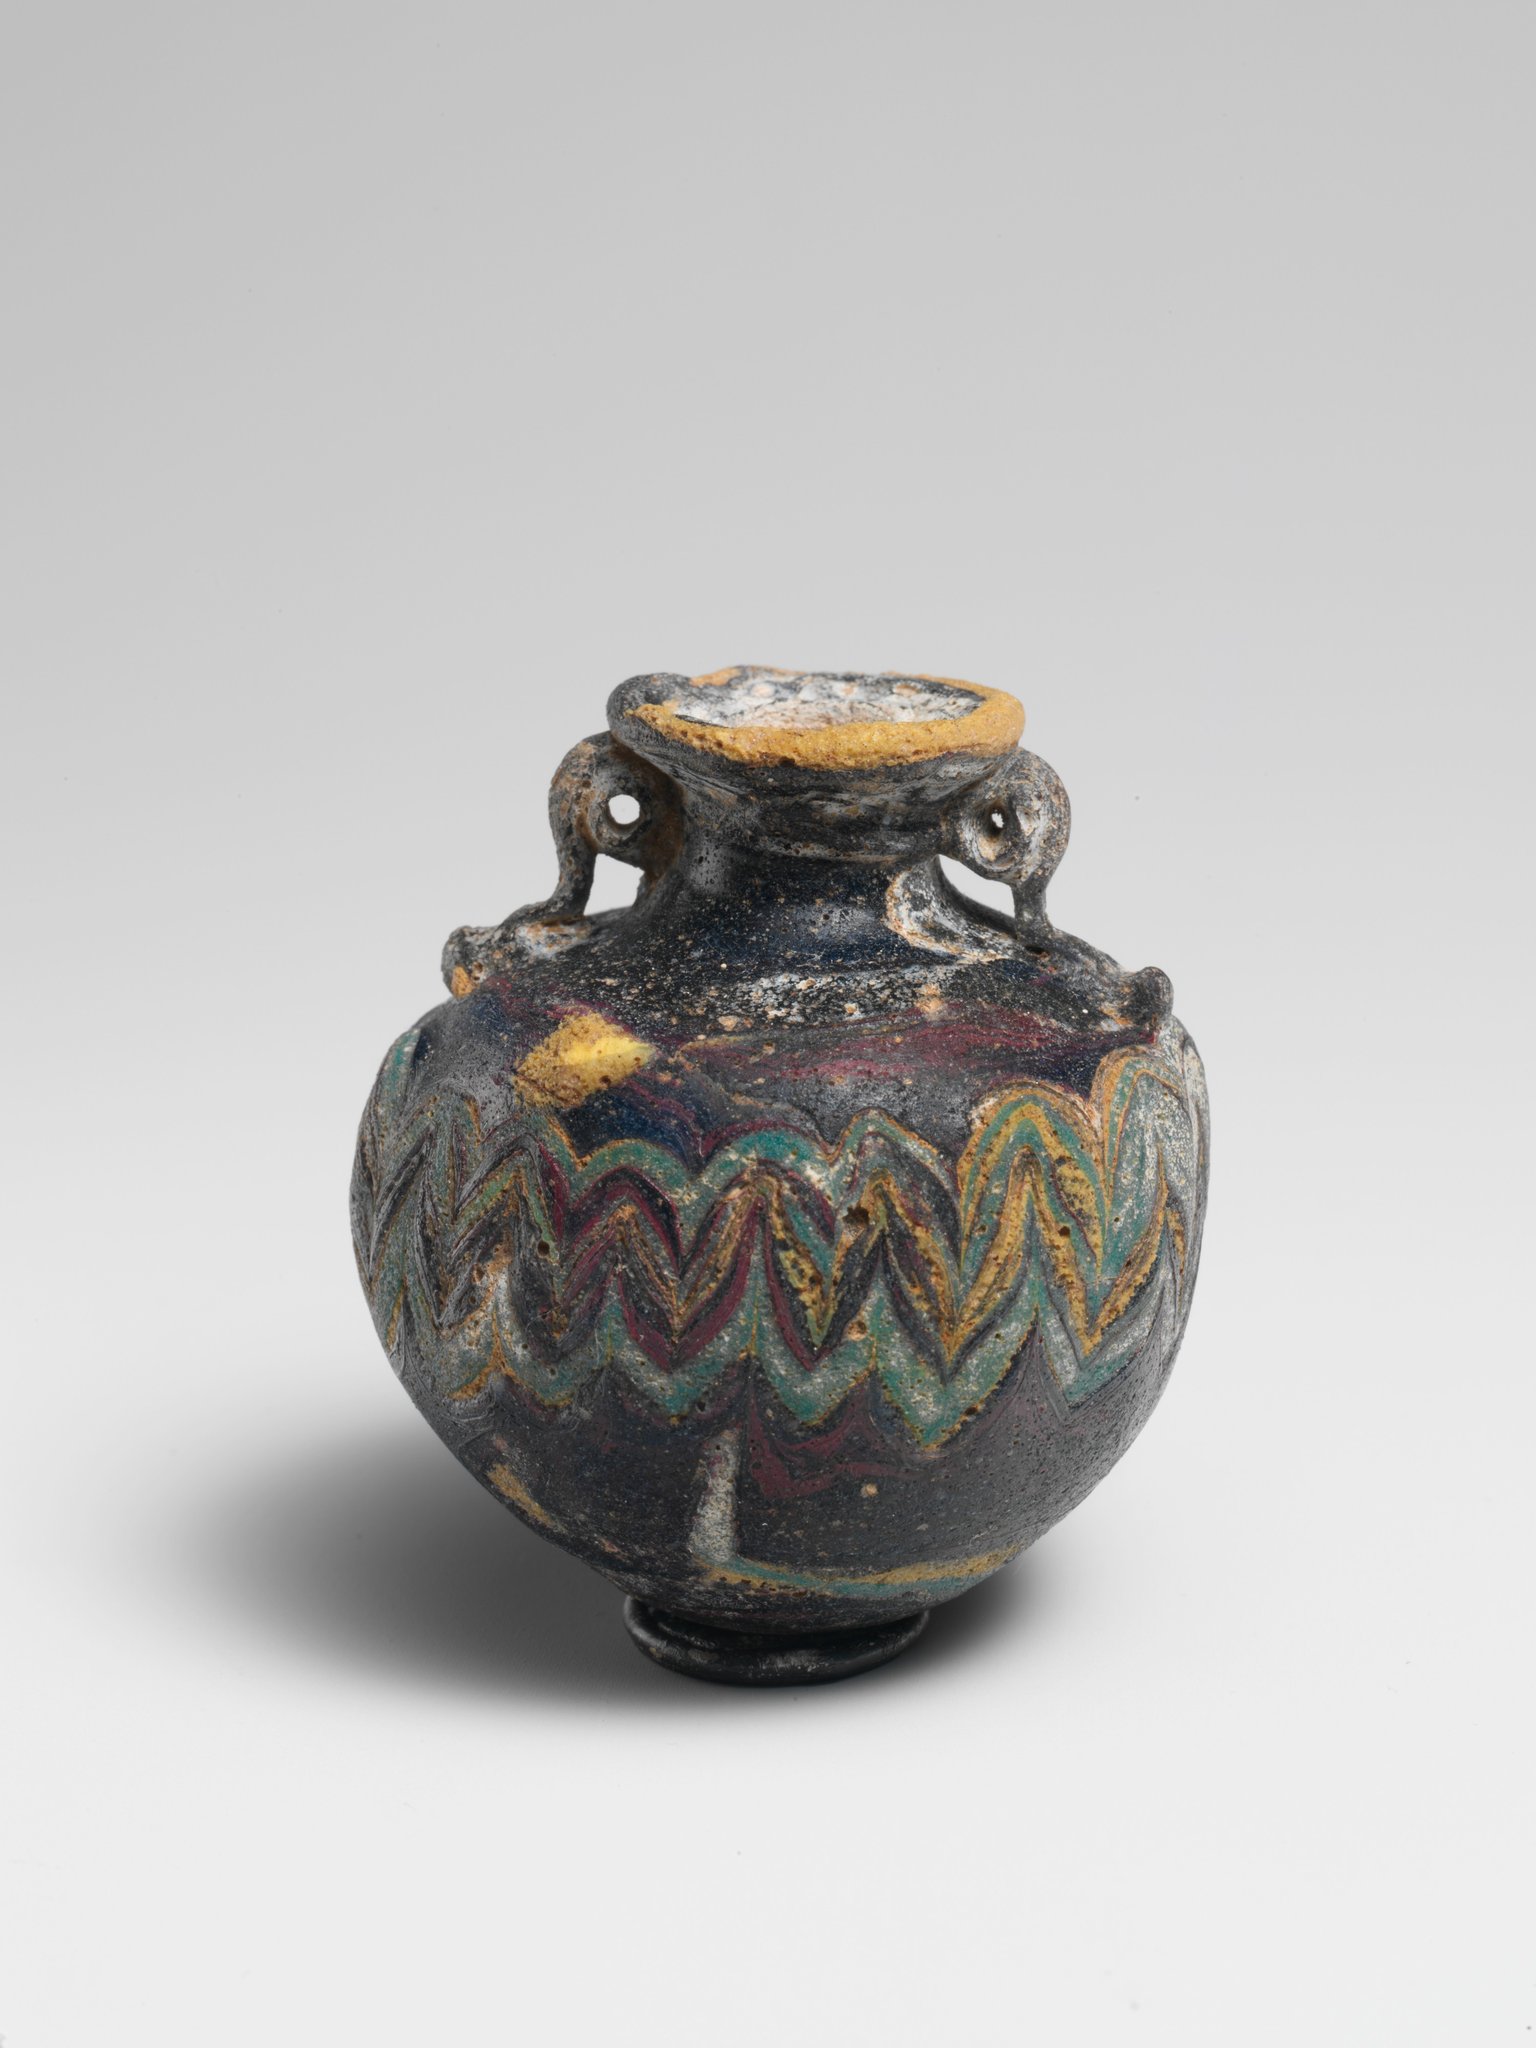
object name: aryballos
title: Glass aryballos (perfume bottle)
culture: greek, eastern mediterranean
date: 500-401 BCE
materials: glass